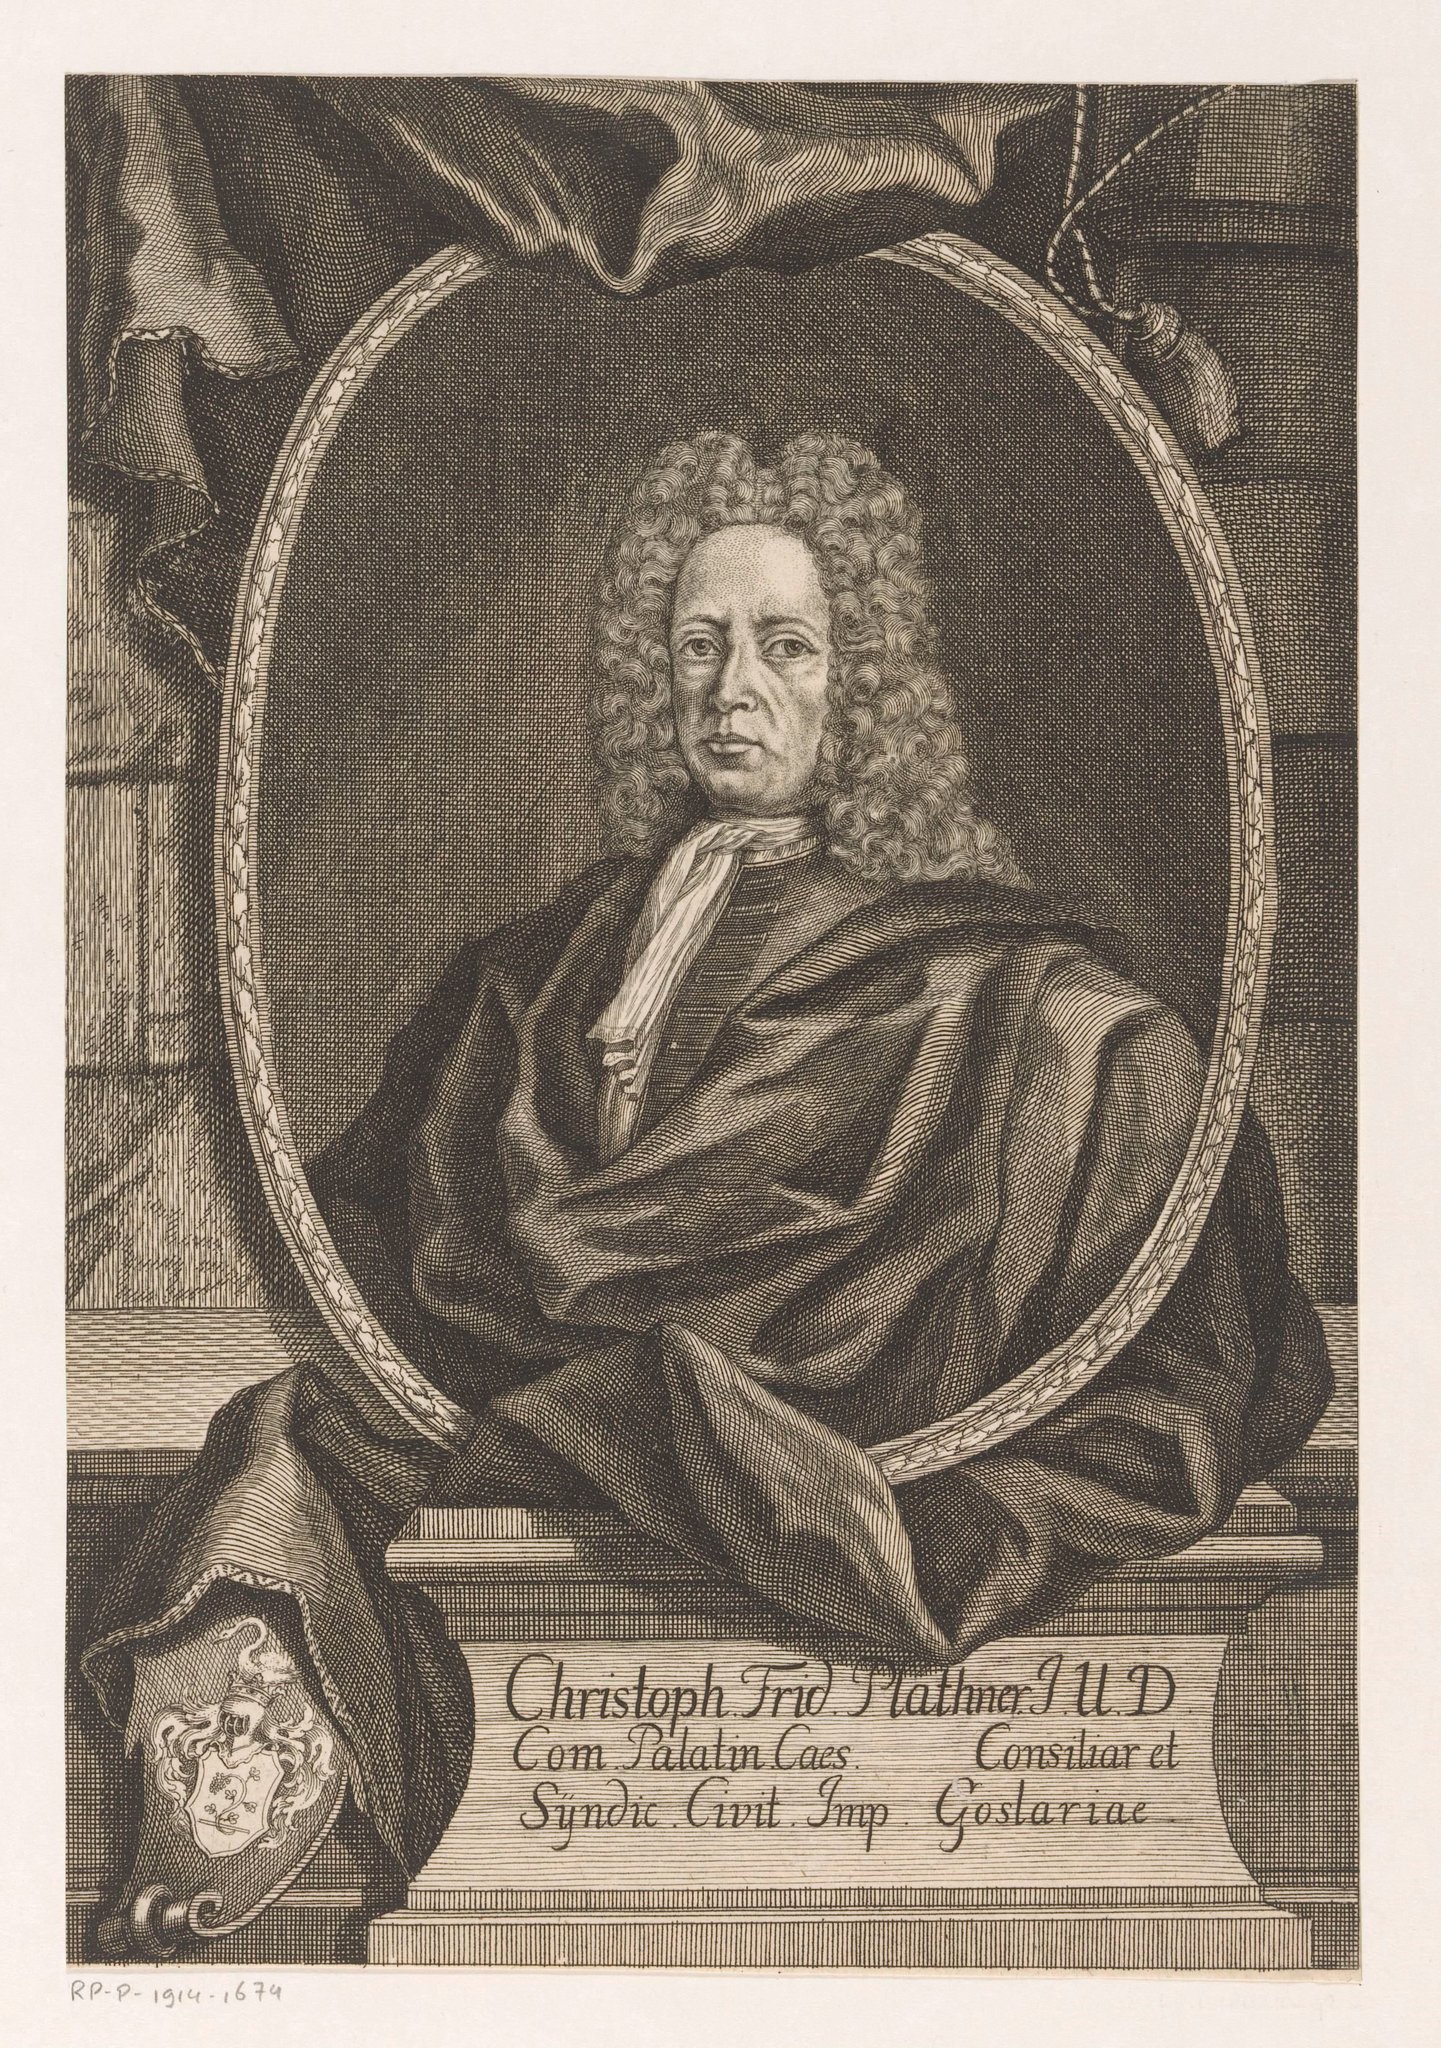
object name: print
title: Portret van Christoph Friedrich Plathner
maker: johann georg beck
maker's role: print maker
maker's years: 1676-1722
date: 1715-1722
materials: paper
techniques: engraving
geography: braunschweig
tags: mühlhausen, historical persons, armorial bearing, heraldry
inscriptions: collector's mark: Lugt 2228